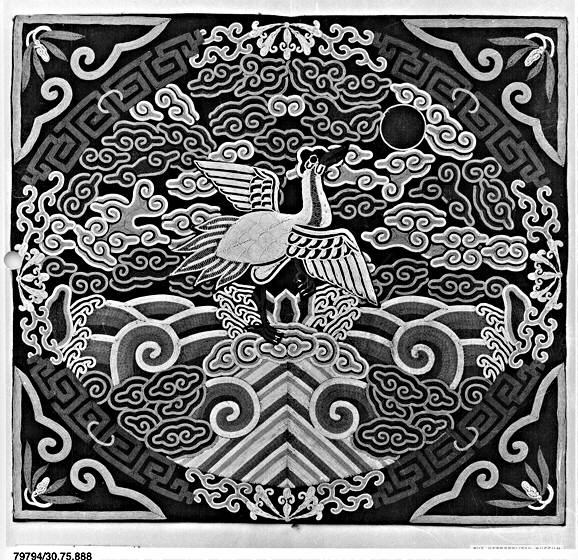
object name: woman's rank badge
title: Woman's Rank Badge with Crane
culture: chinese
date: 1767-1833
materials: silk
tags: cranes